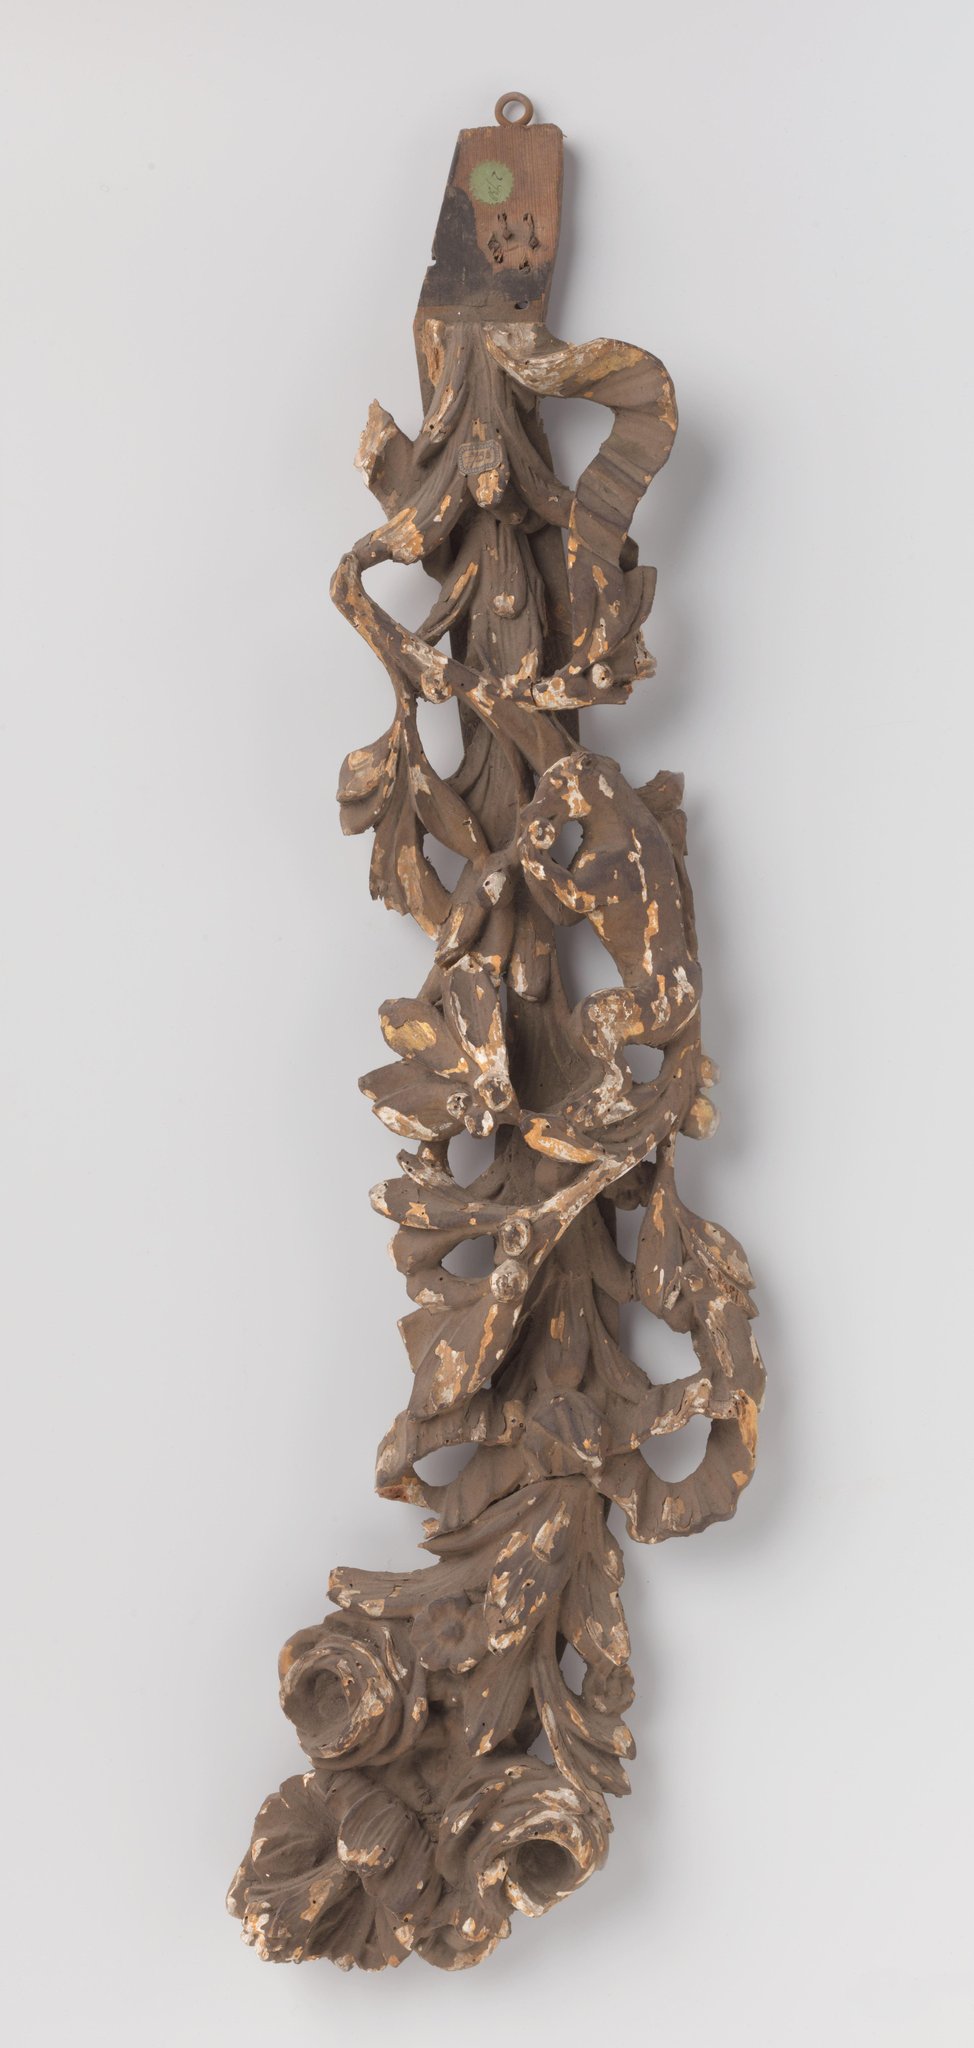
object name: architectural element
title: Bouwfragment van hout met festoen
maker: Anonymous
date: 1400-1950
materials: wood